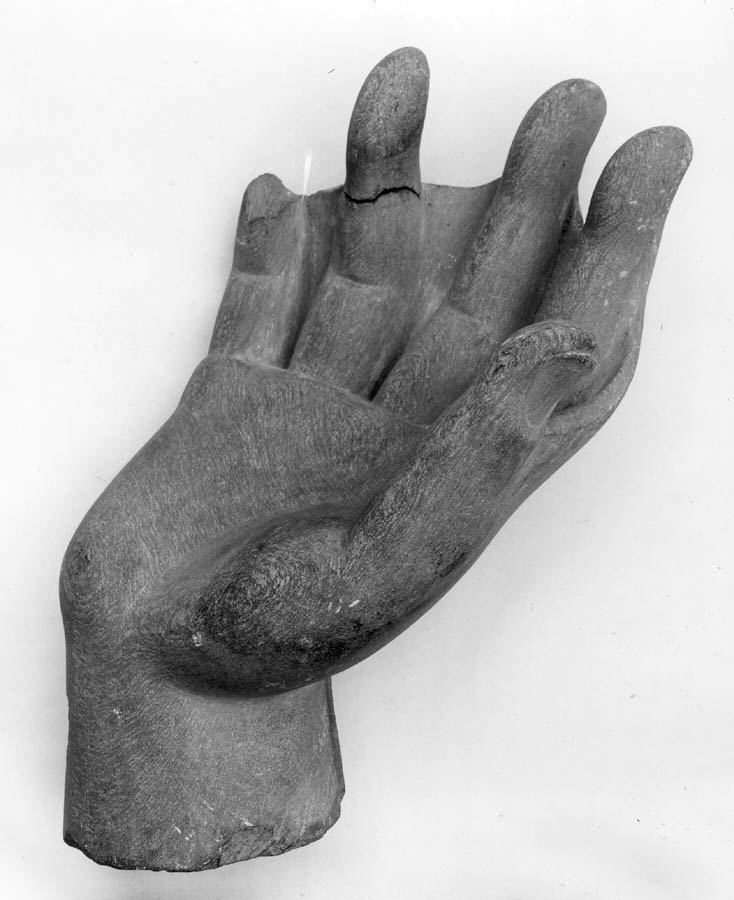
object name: hand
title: Right Hand of the Buddha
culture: gandhara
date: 1-200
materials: stone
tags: gandhara,hands